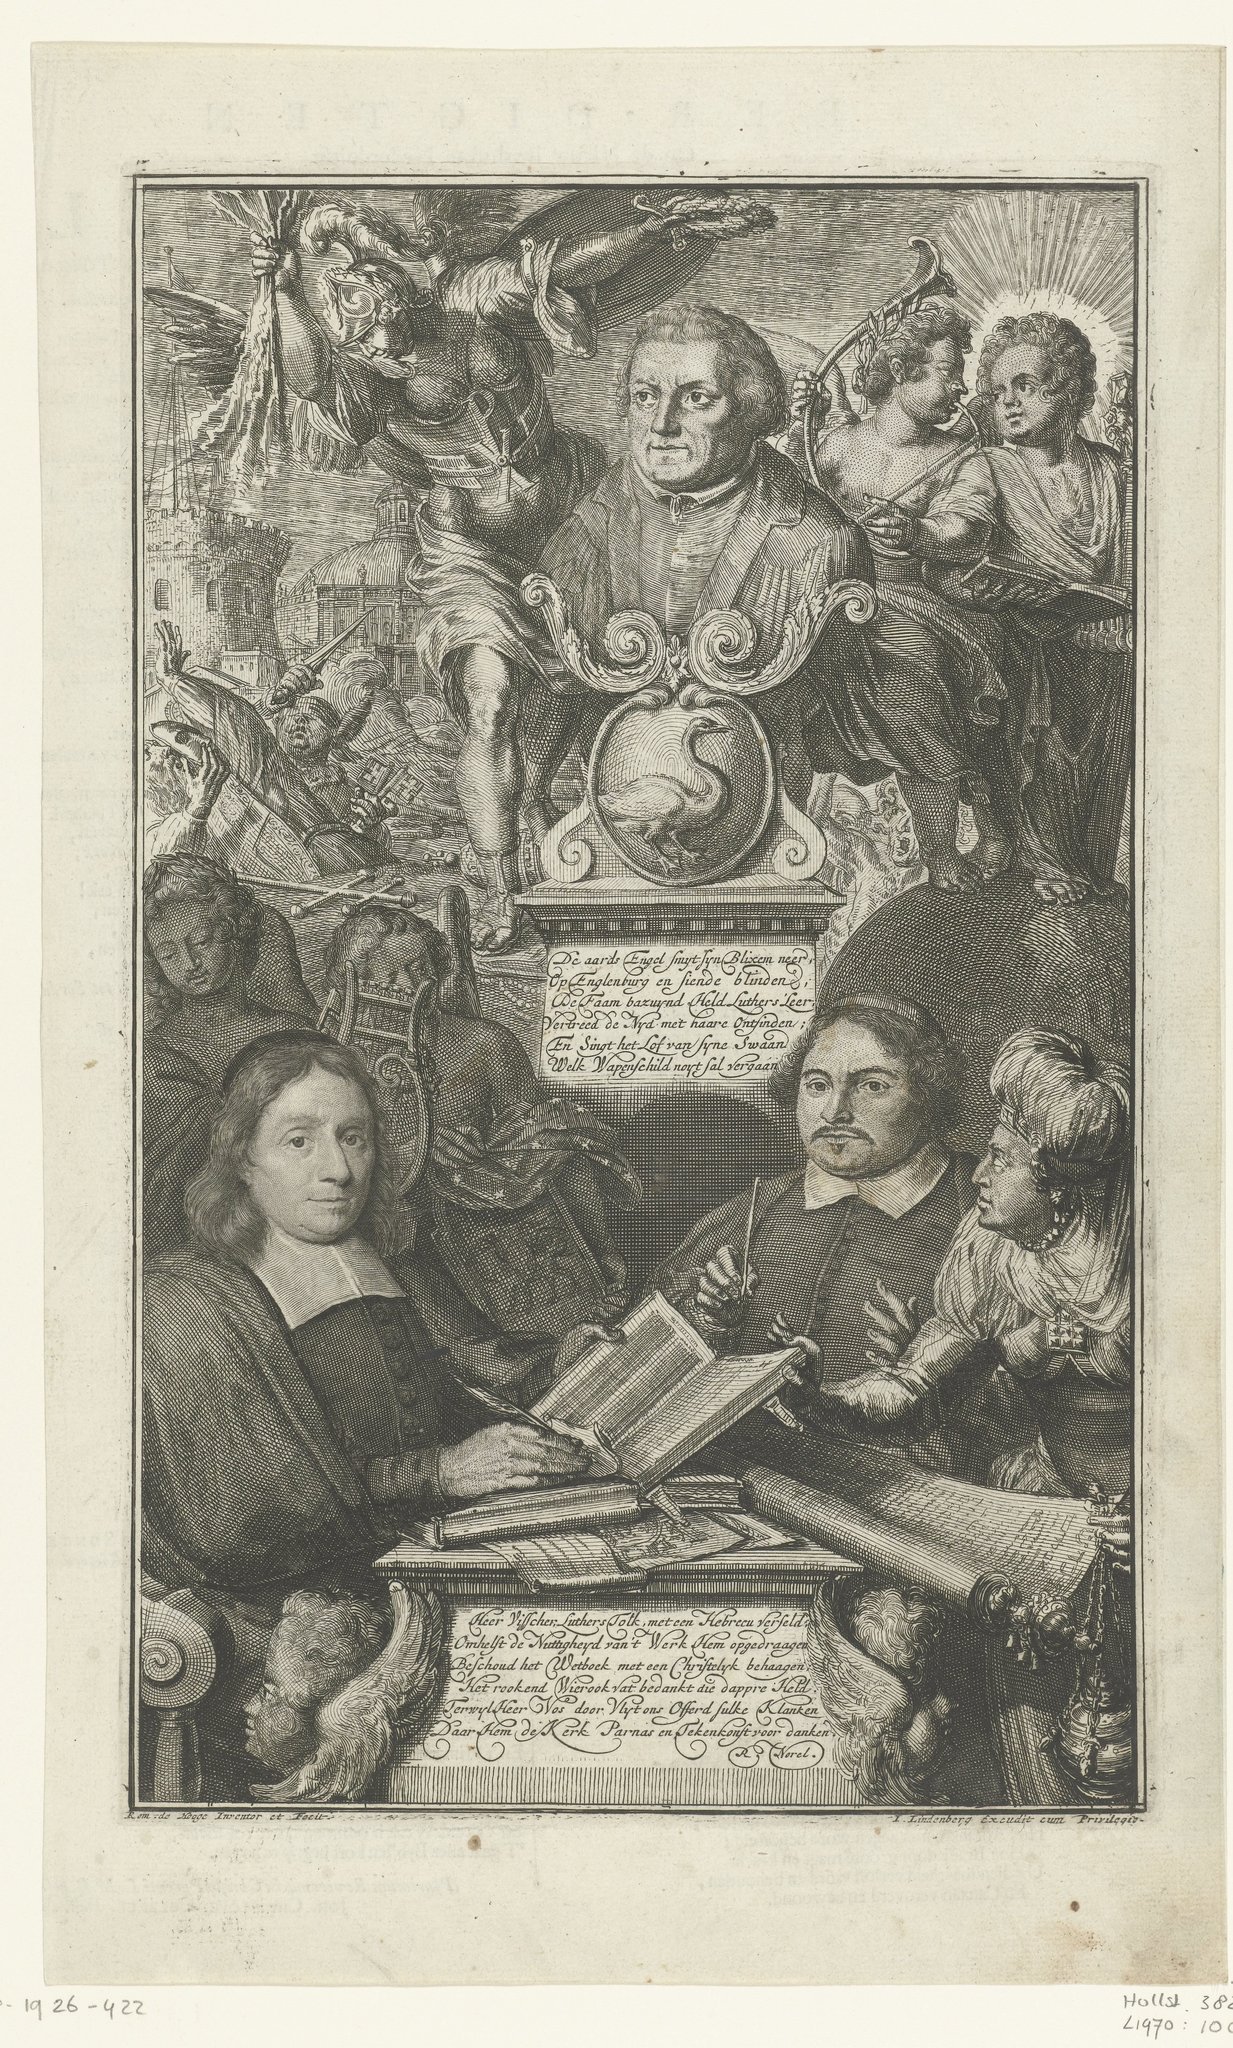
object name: book illustration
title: Allegorische voorstelling met Maarten Luther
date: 1703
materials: paper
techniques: engraving, etching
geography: netherlands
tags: adolf visscher (1605-1652), amsterdam, henricus vos, priest, martin luther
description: Allegorische voorstelling met Maarten Luther. Buste van Maarten Luther met tekst eronder. Daaronder bustes van Adolphus Visscher en Henricus Vos, eveneens met tekst eronder. Op achterzijde blad tekst in boekdruk.